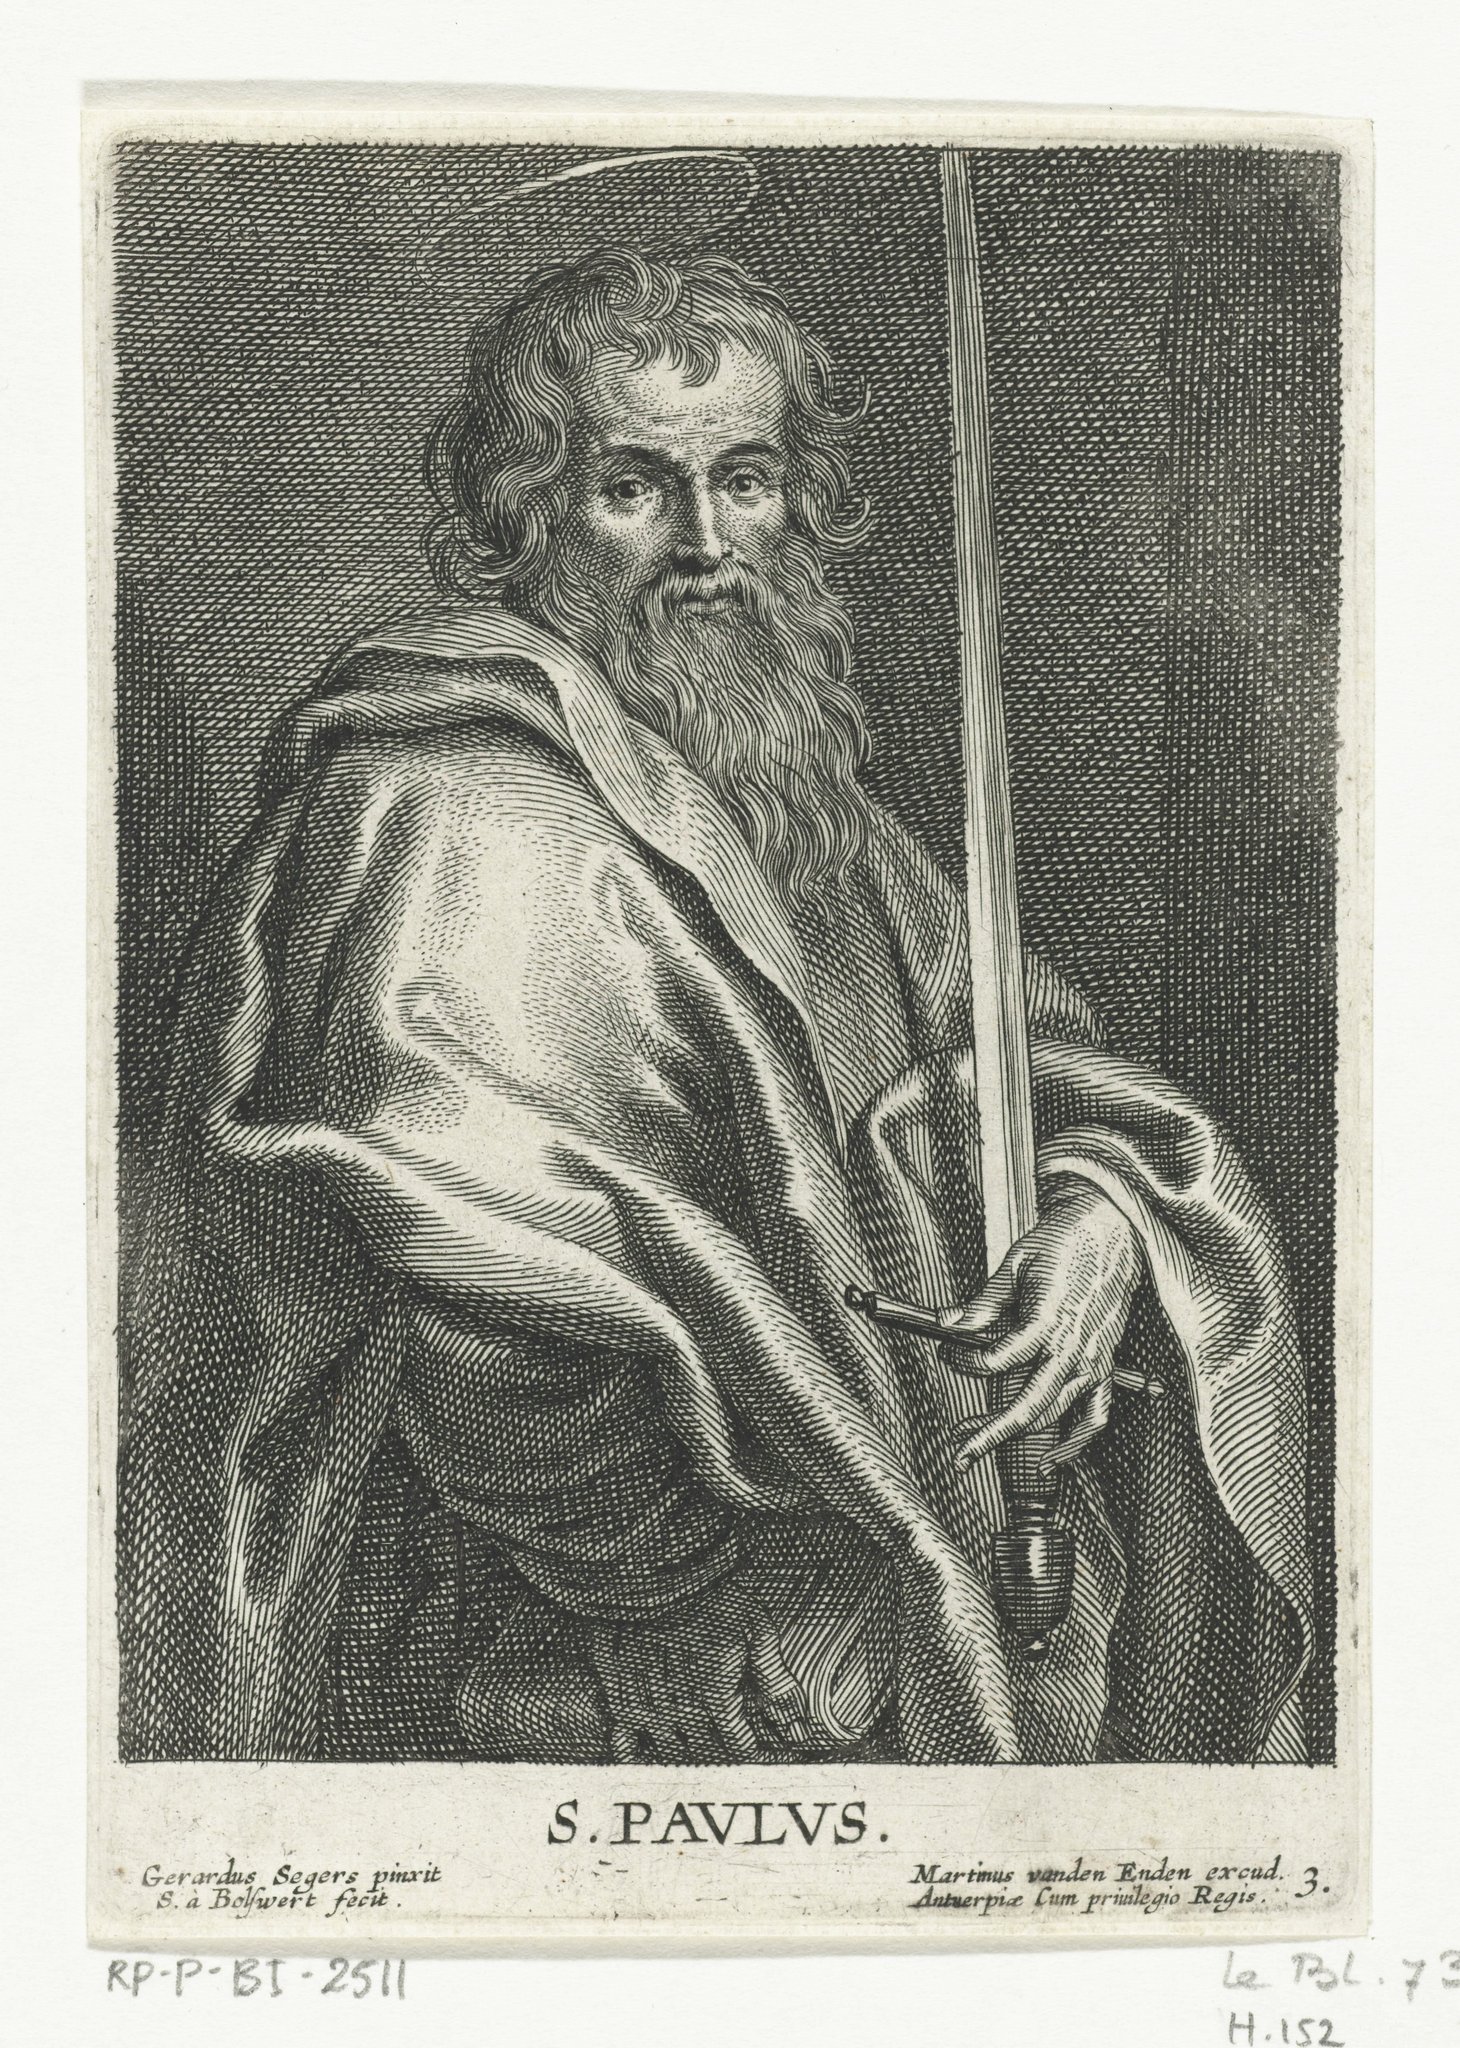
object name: print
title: H. Pavlvs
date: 1596-1659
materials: paper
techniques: engraving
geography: antwerp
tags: the apostle paul of tarsus; possible attributes: book, scroll, sword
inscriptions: collector's mark: Lugt 240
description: Prent uit serie met veertien prenten met Christus, Paulus en twaalf apostelen naar schilderijen van Gerard Seghers.